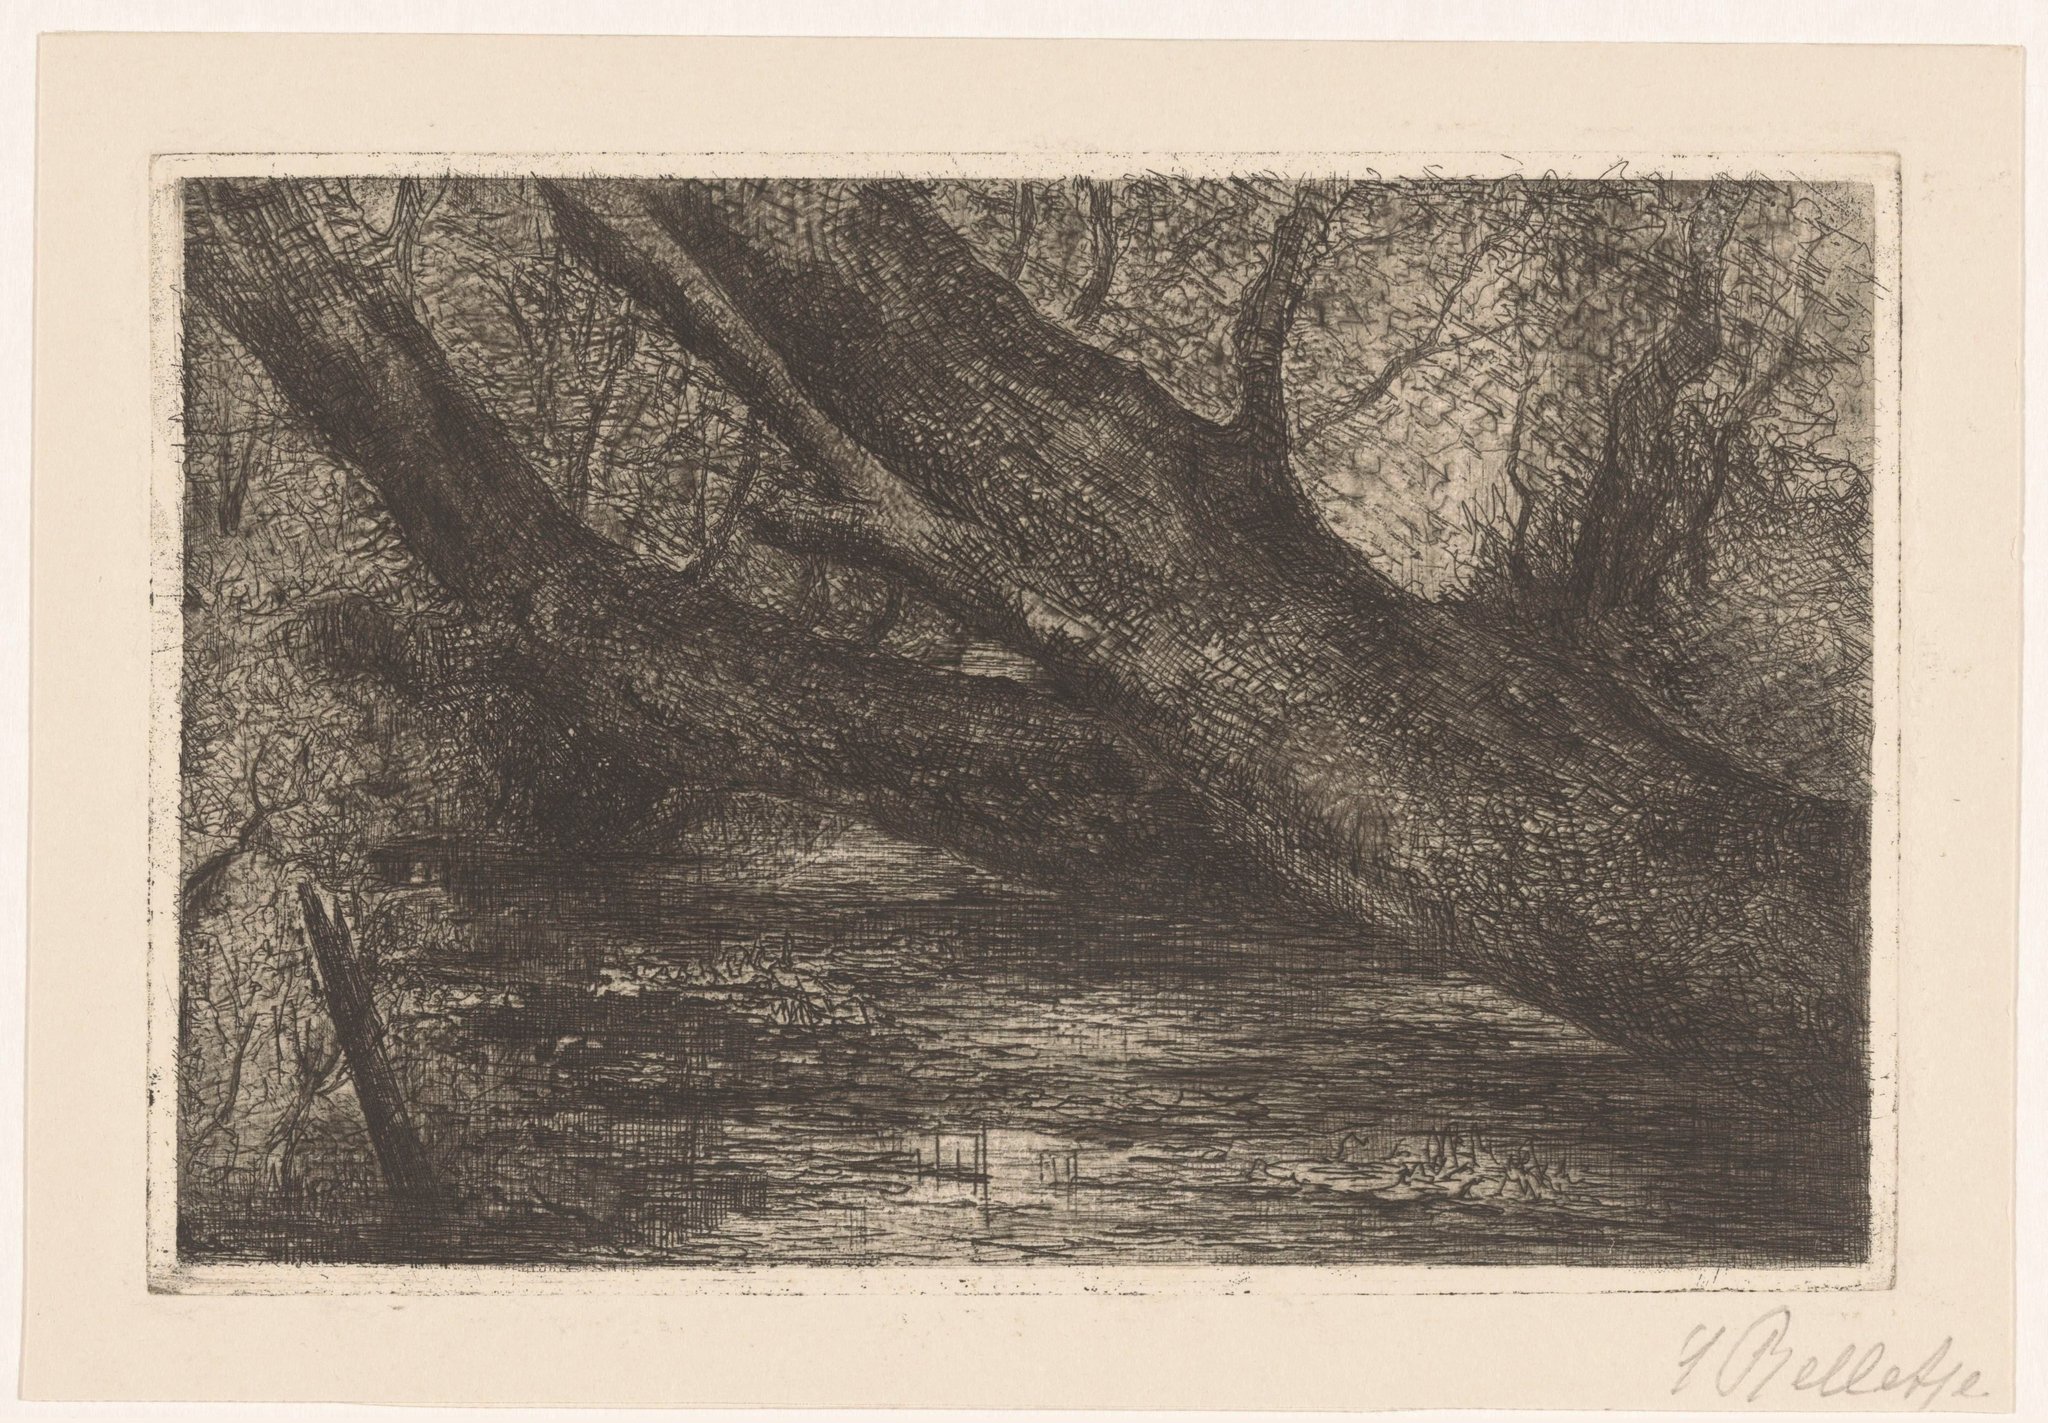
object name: print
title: 't Relletje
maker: cornelia christina johanna van trigt-hoevenaar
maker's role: print maker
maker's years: 1854-1924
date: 1864-1910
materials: paper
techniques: etching, intaglio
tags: trees, pond, pool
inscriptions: collector's mark: Lugt 2228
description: Rechts hangen twee bomen boven het water.